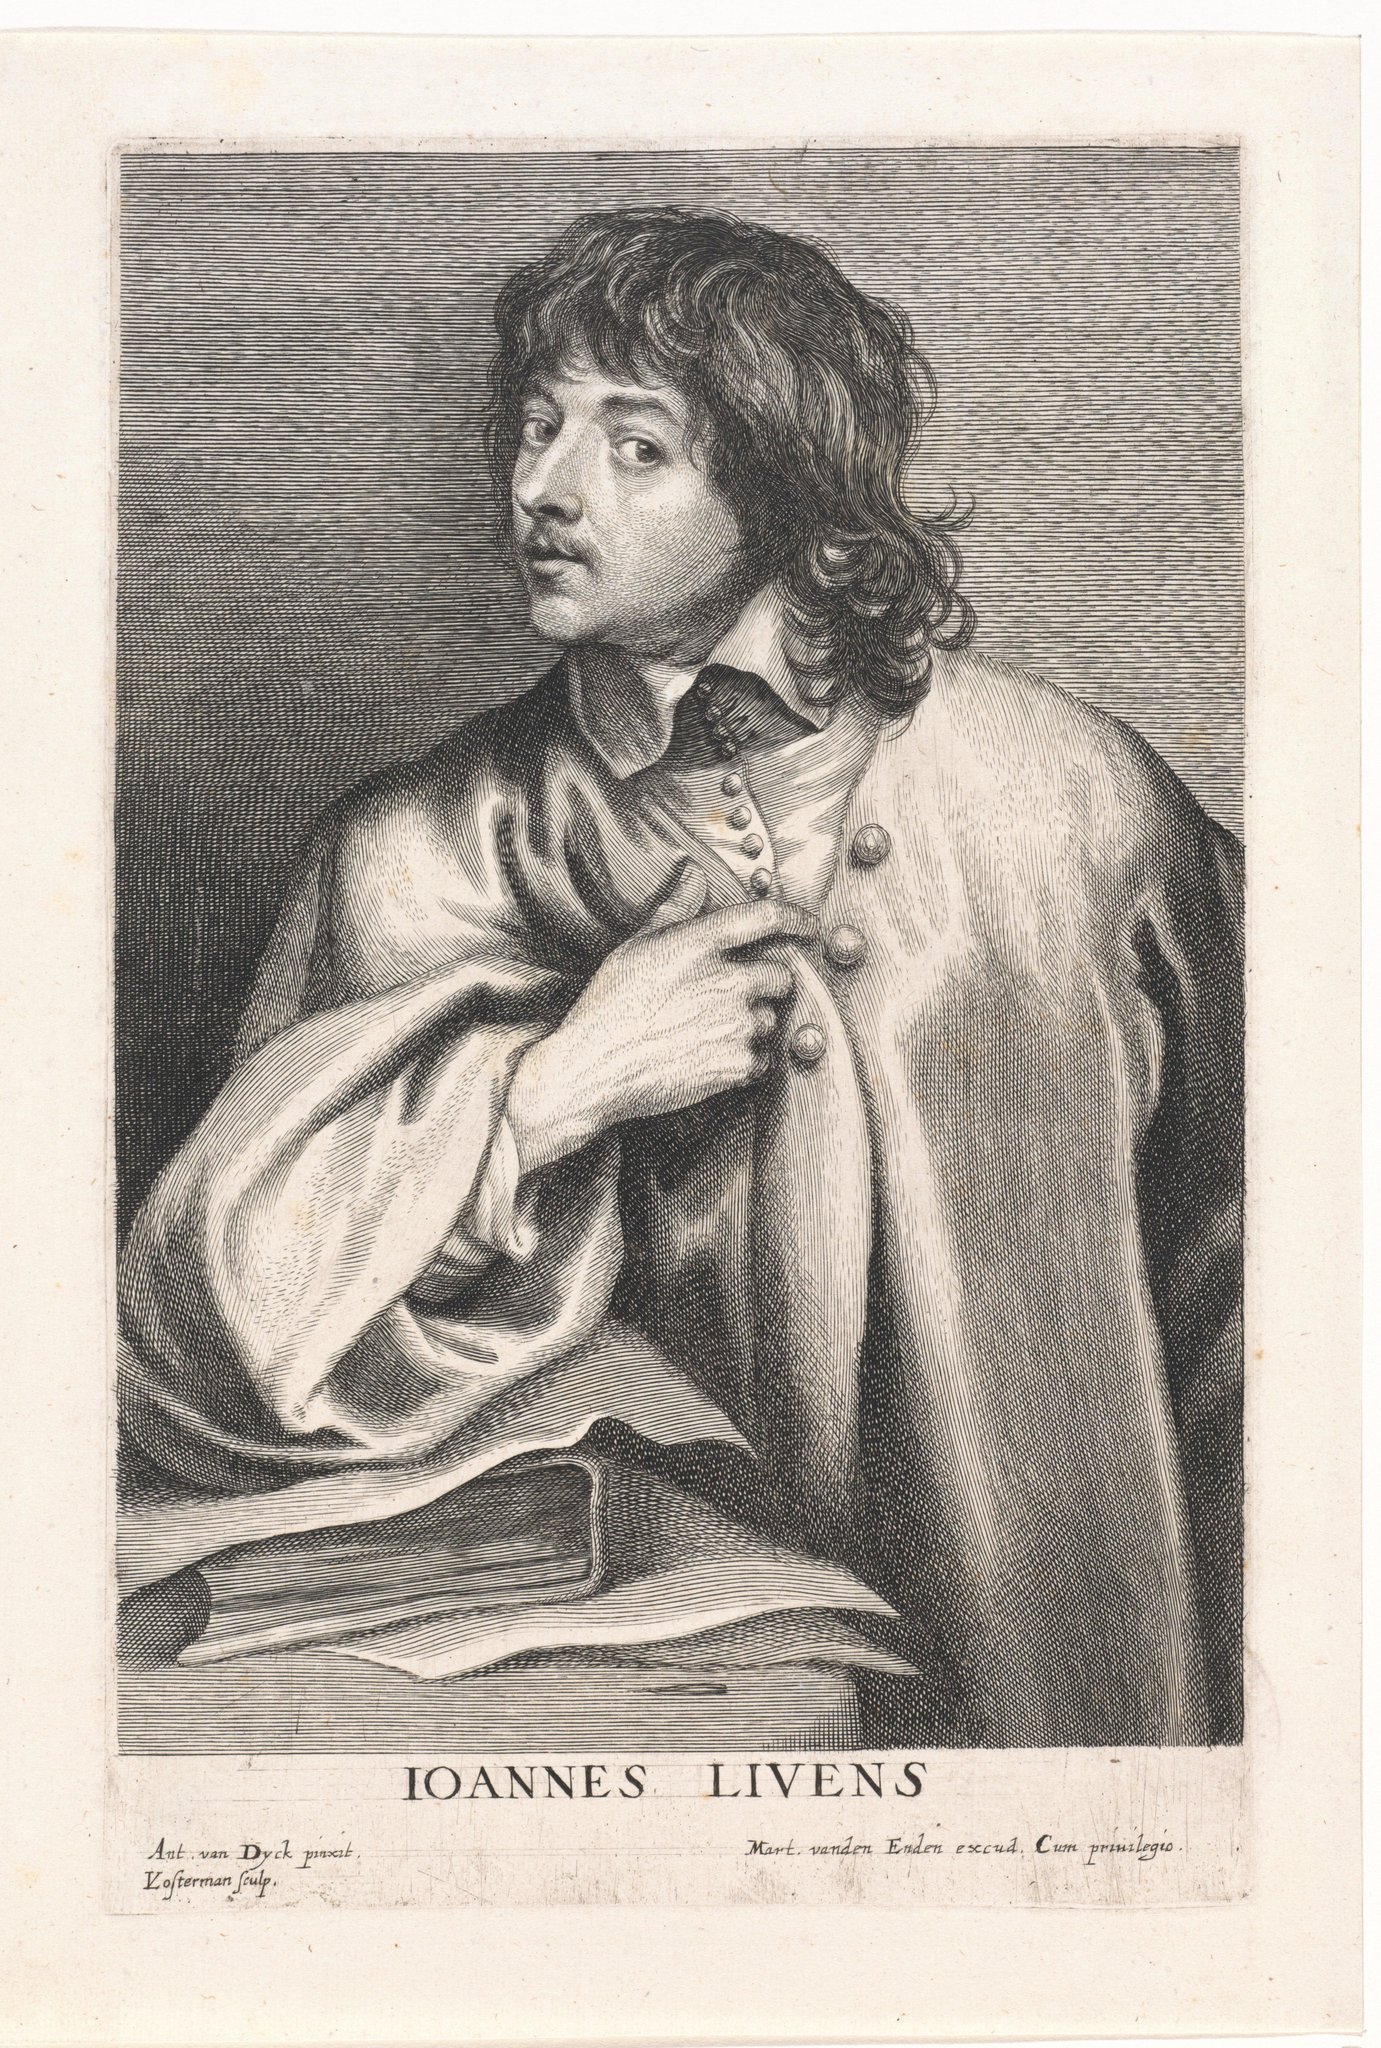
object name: print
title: Iconographie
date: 1630-1646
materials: paper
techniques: engraving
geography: antwerp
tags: leiden, amsterdam, painter, print maker, draughtsman, jan lievens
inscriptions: collector's mark: Lugt 240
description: Prent gebruikt voor: Icones principum, virorum doctorum, pictorum, chalcographorum, statuariorum nec non amatorum pictoriae artis numero centum ab Ant. van Dyck ad vivum expressae ejusque sumptibus aeri incisae. Antwerpen: Gillis Hendricx, [1645-1646].